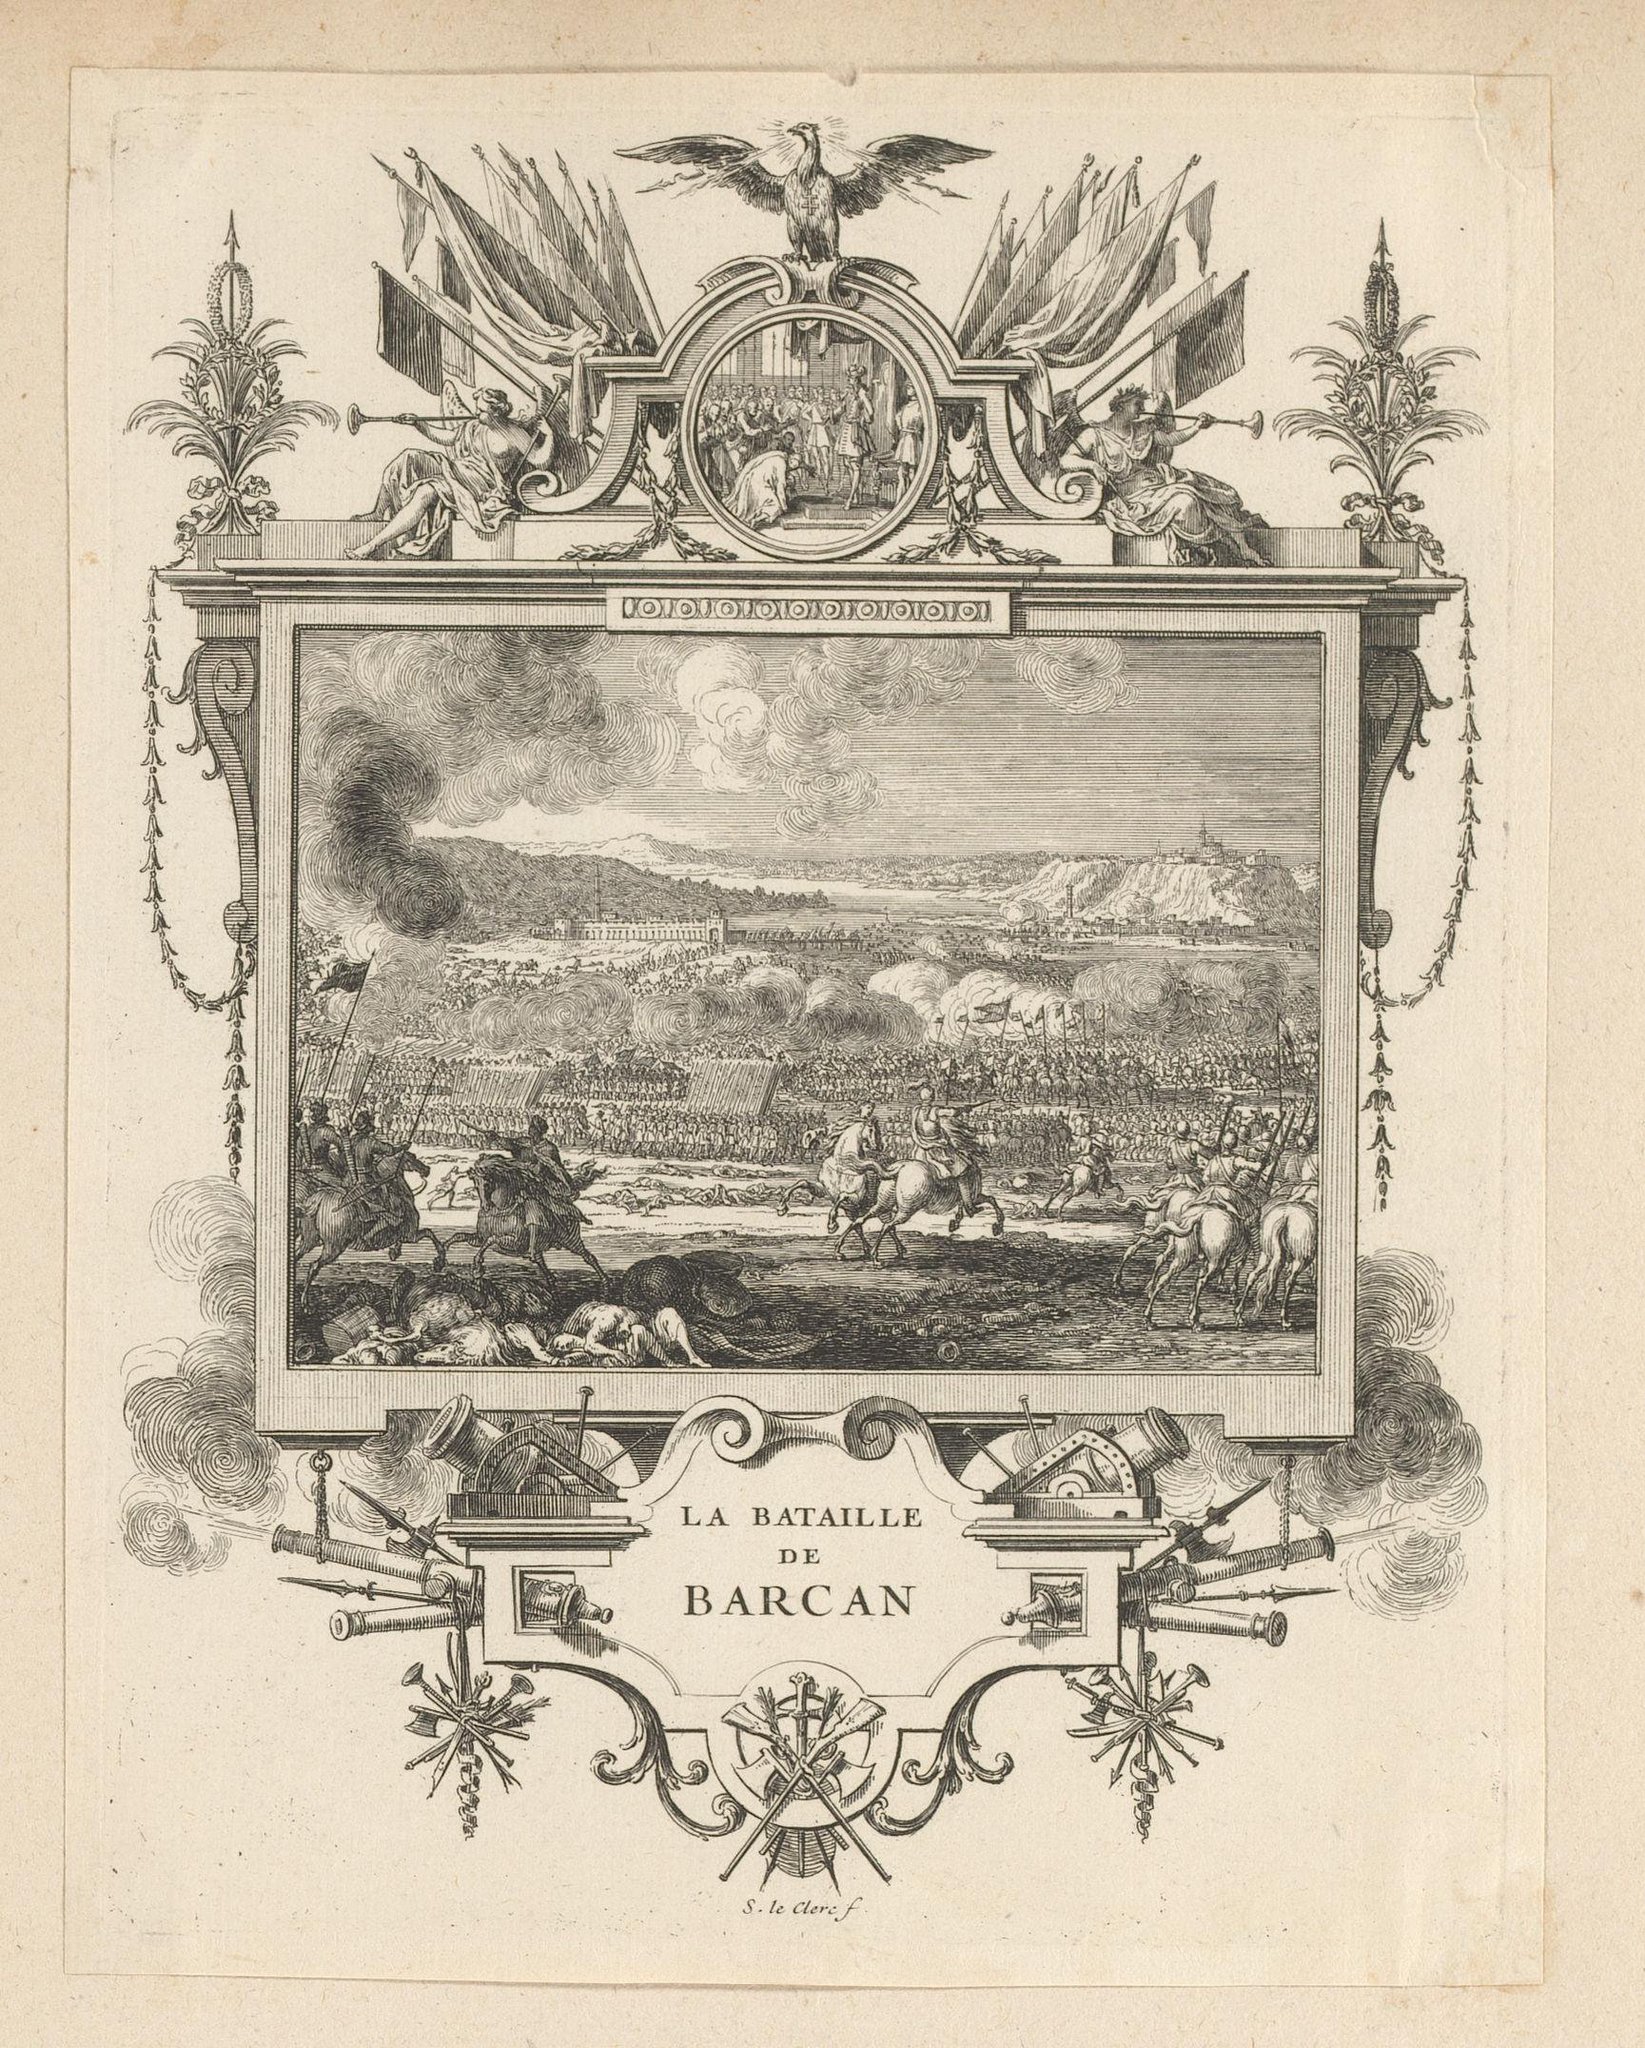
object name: print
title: Histoire de Charles V duc de Lorraine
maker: sébastien leclerc (i)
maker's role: print maker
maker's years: 1637-1714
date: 1704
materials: paper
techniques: etching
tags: vienna, historical persons, battle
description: Prent maakt deel uit van een serie van 37 prenten met veldslagen waar Karel V Leopold, hertog van Lotharingen, aan deelgenomen heeft.